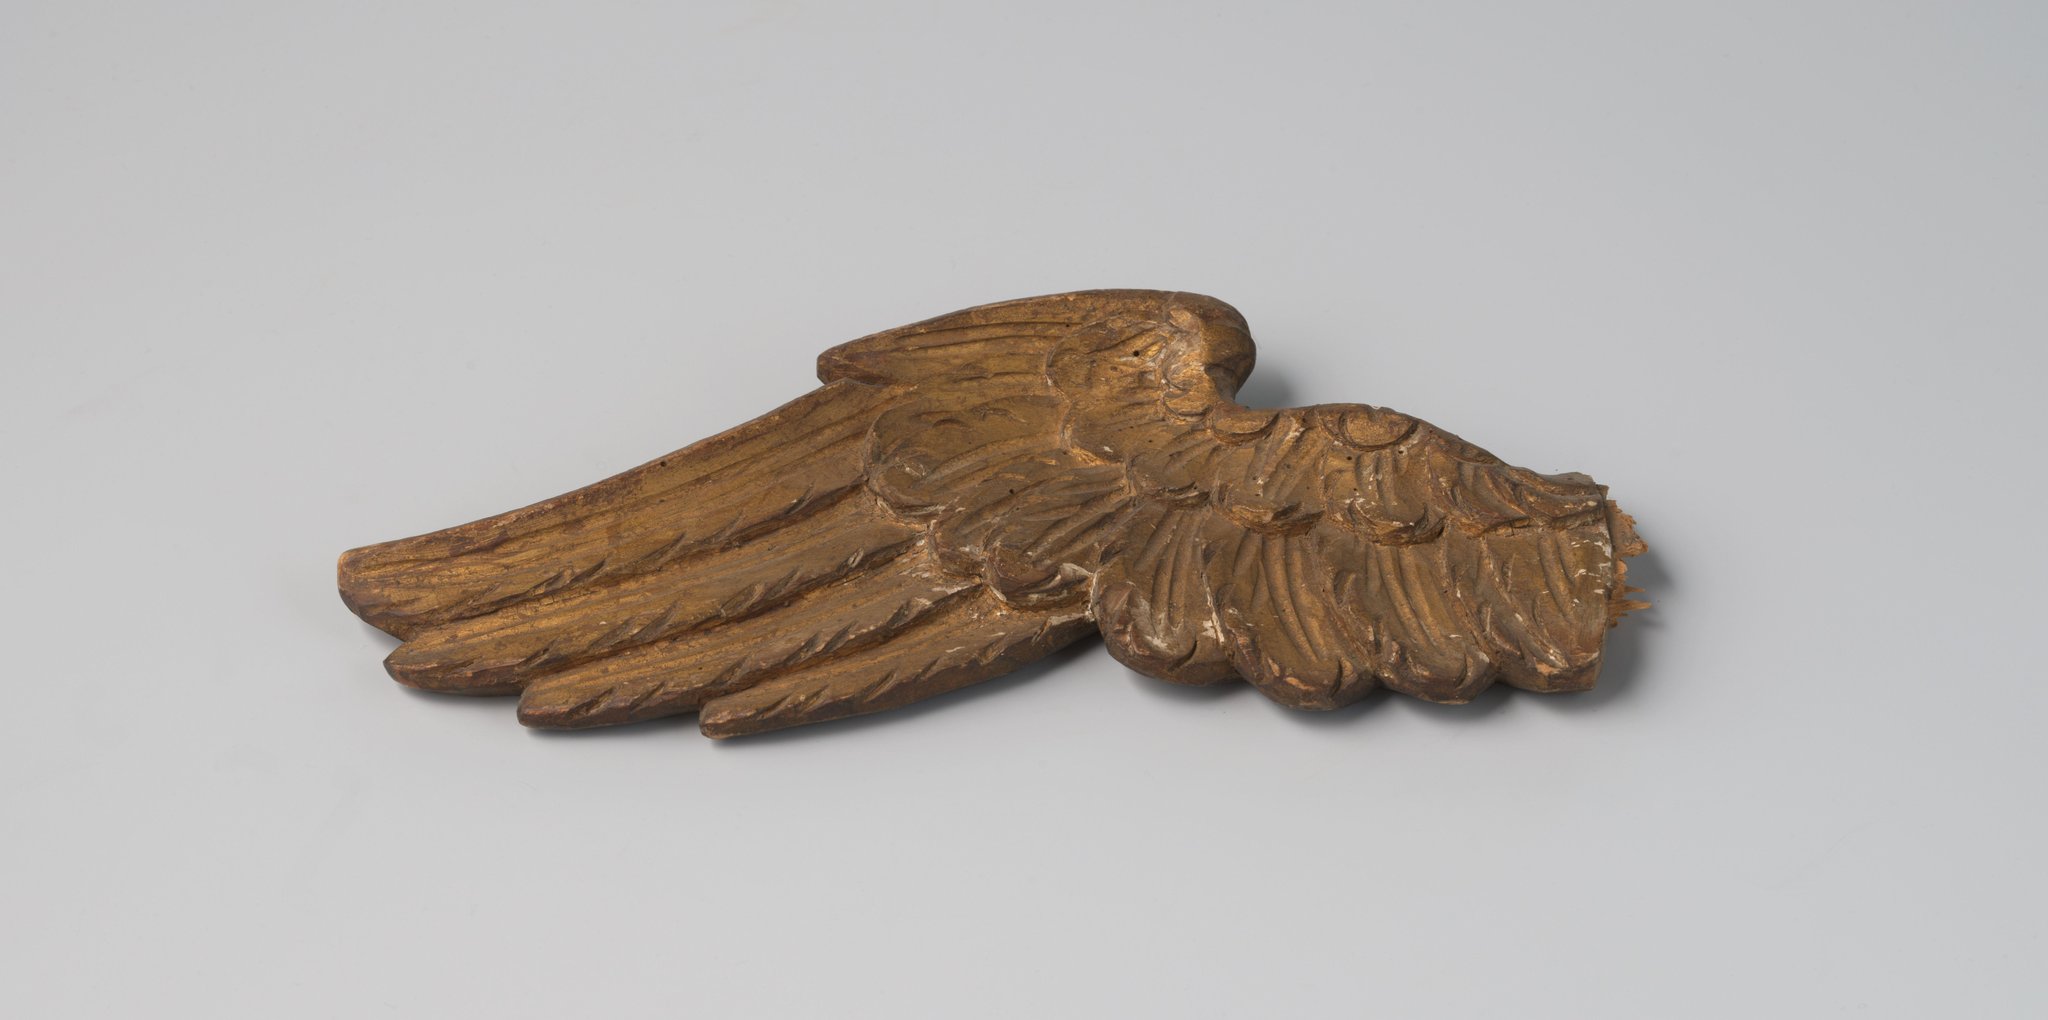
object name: fragment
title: Fragment van een vleugel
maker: Anonymous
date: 1650-1800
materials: wood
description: Een met goudverf beschilderde vleugel van een griffioen welke is afgebroken van het wapenbord.